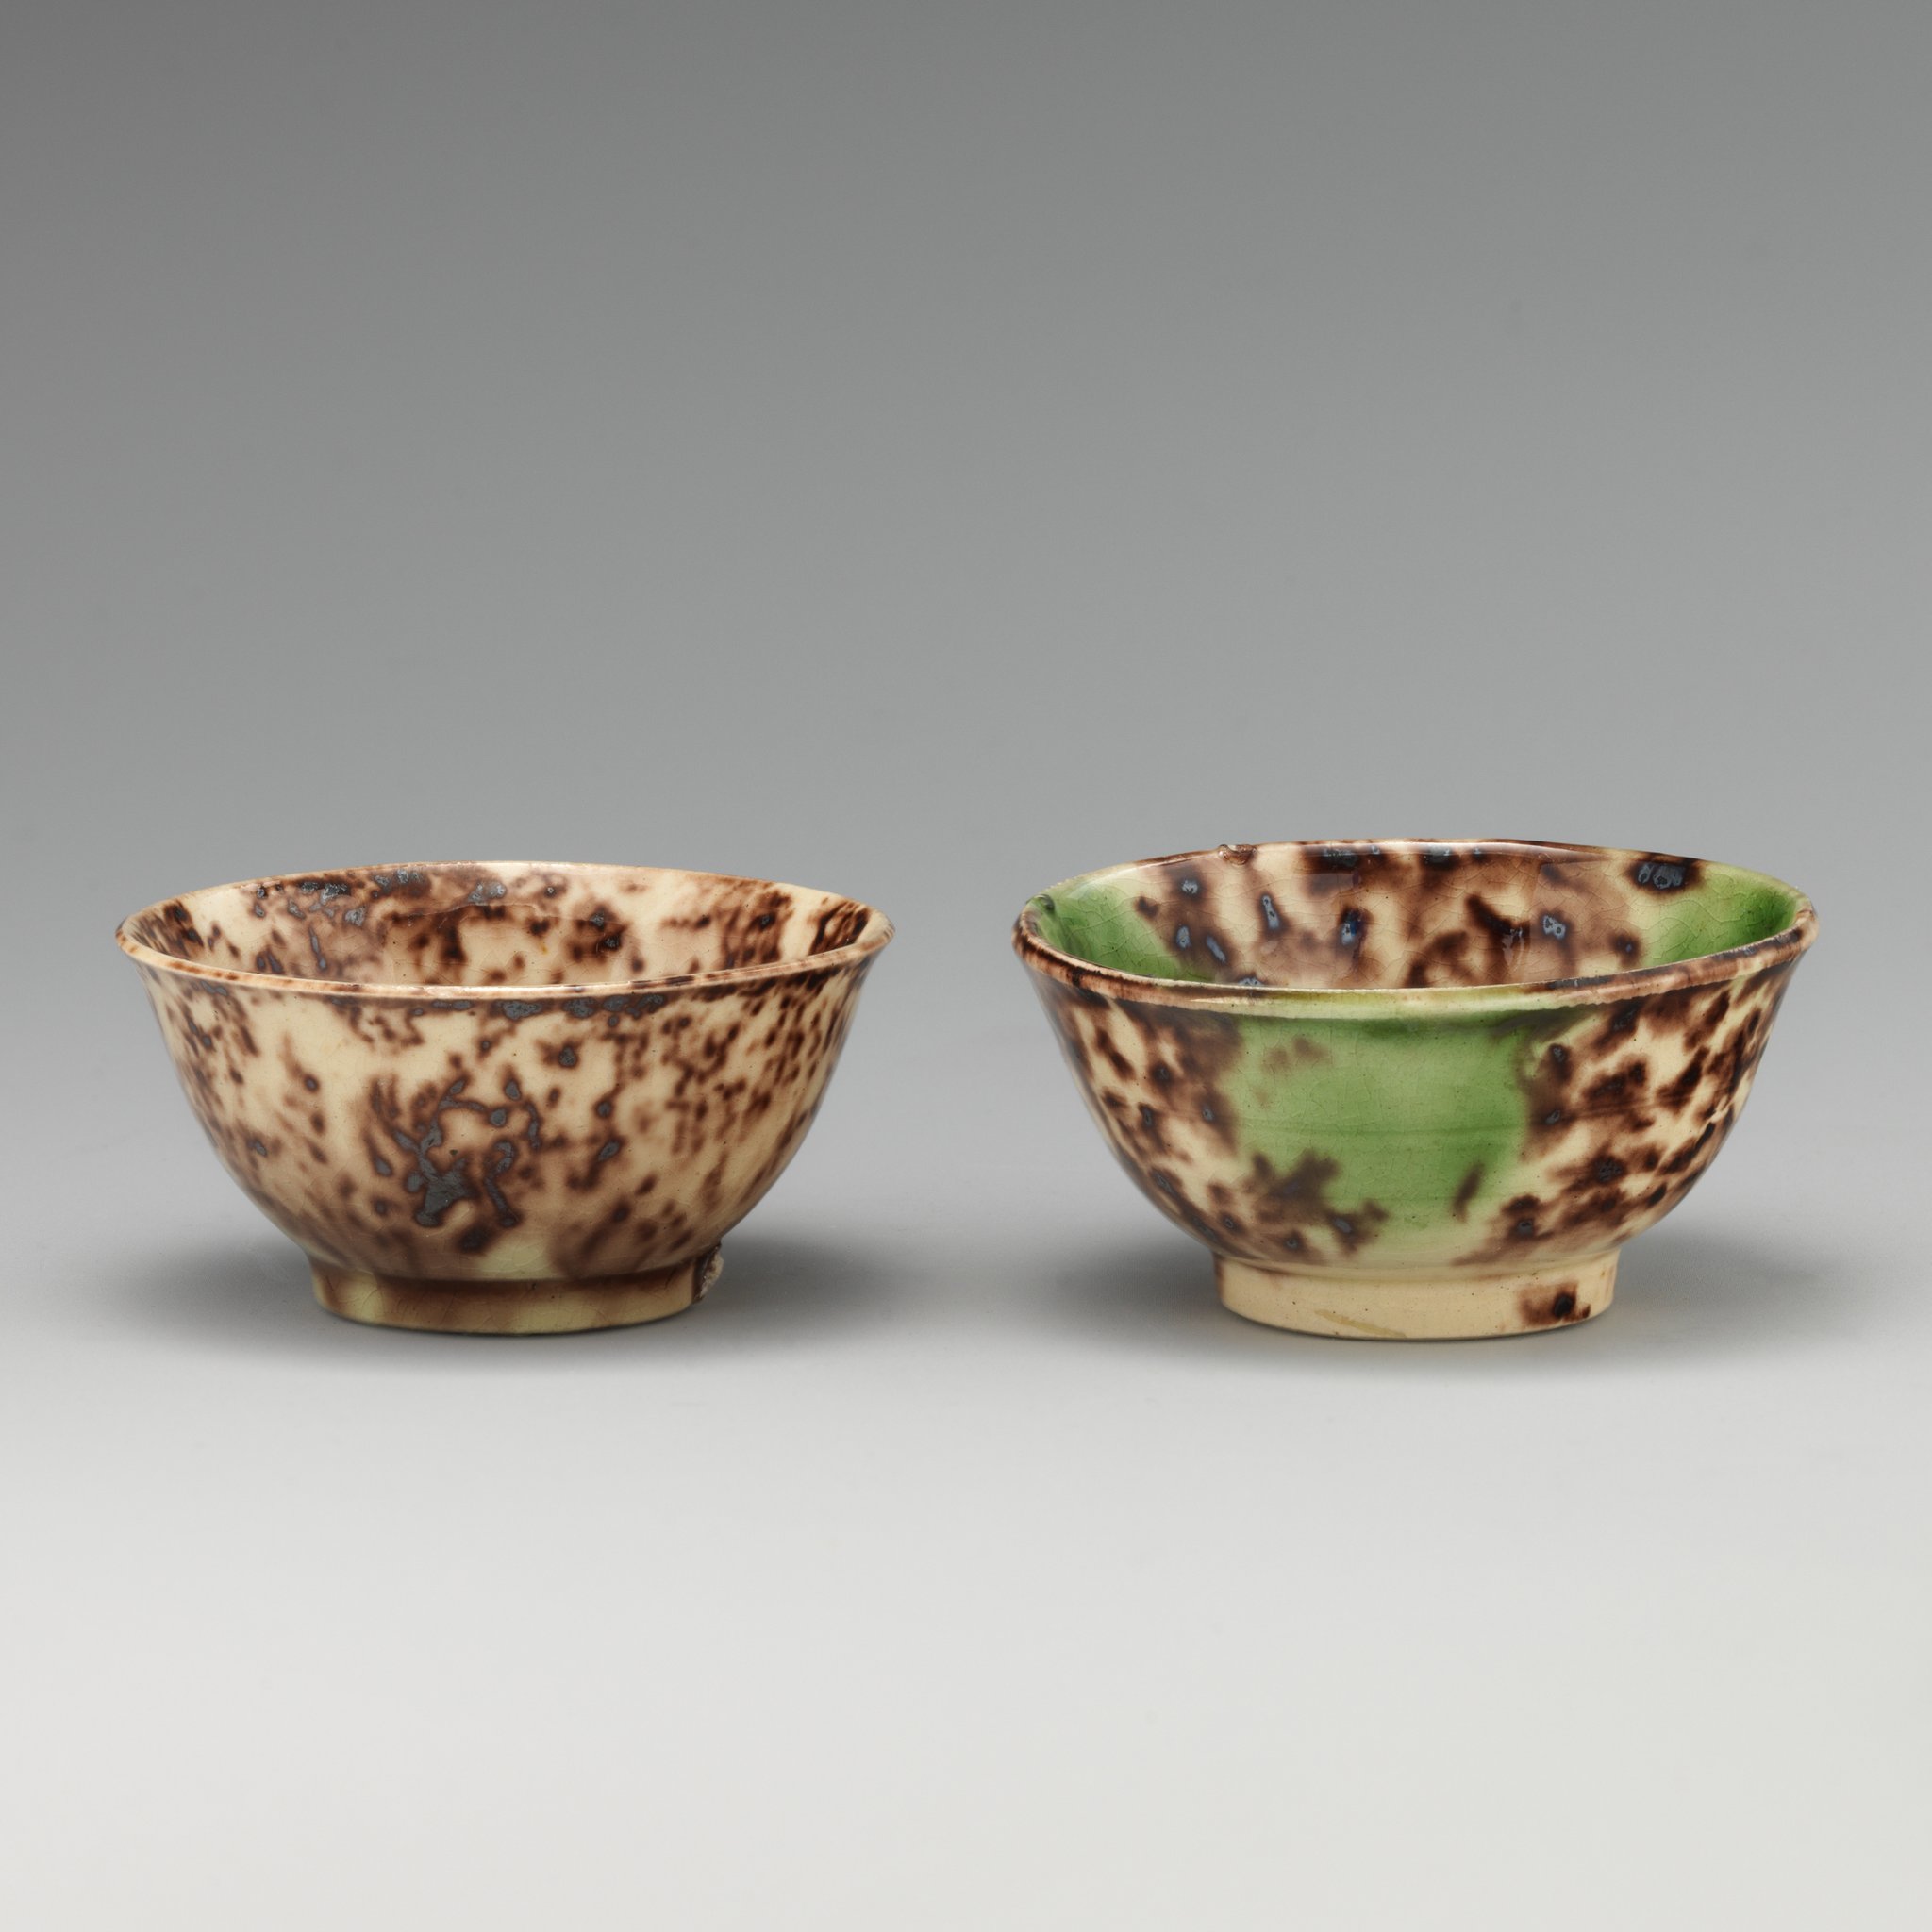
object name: bowl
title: Pair of miniature bowls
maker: whieldon type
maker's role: maker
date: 1751-1775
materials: earthenware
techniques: glazing